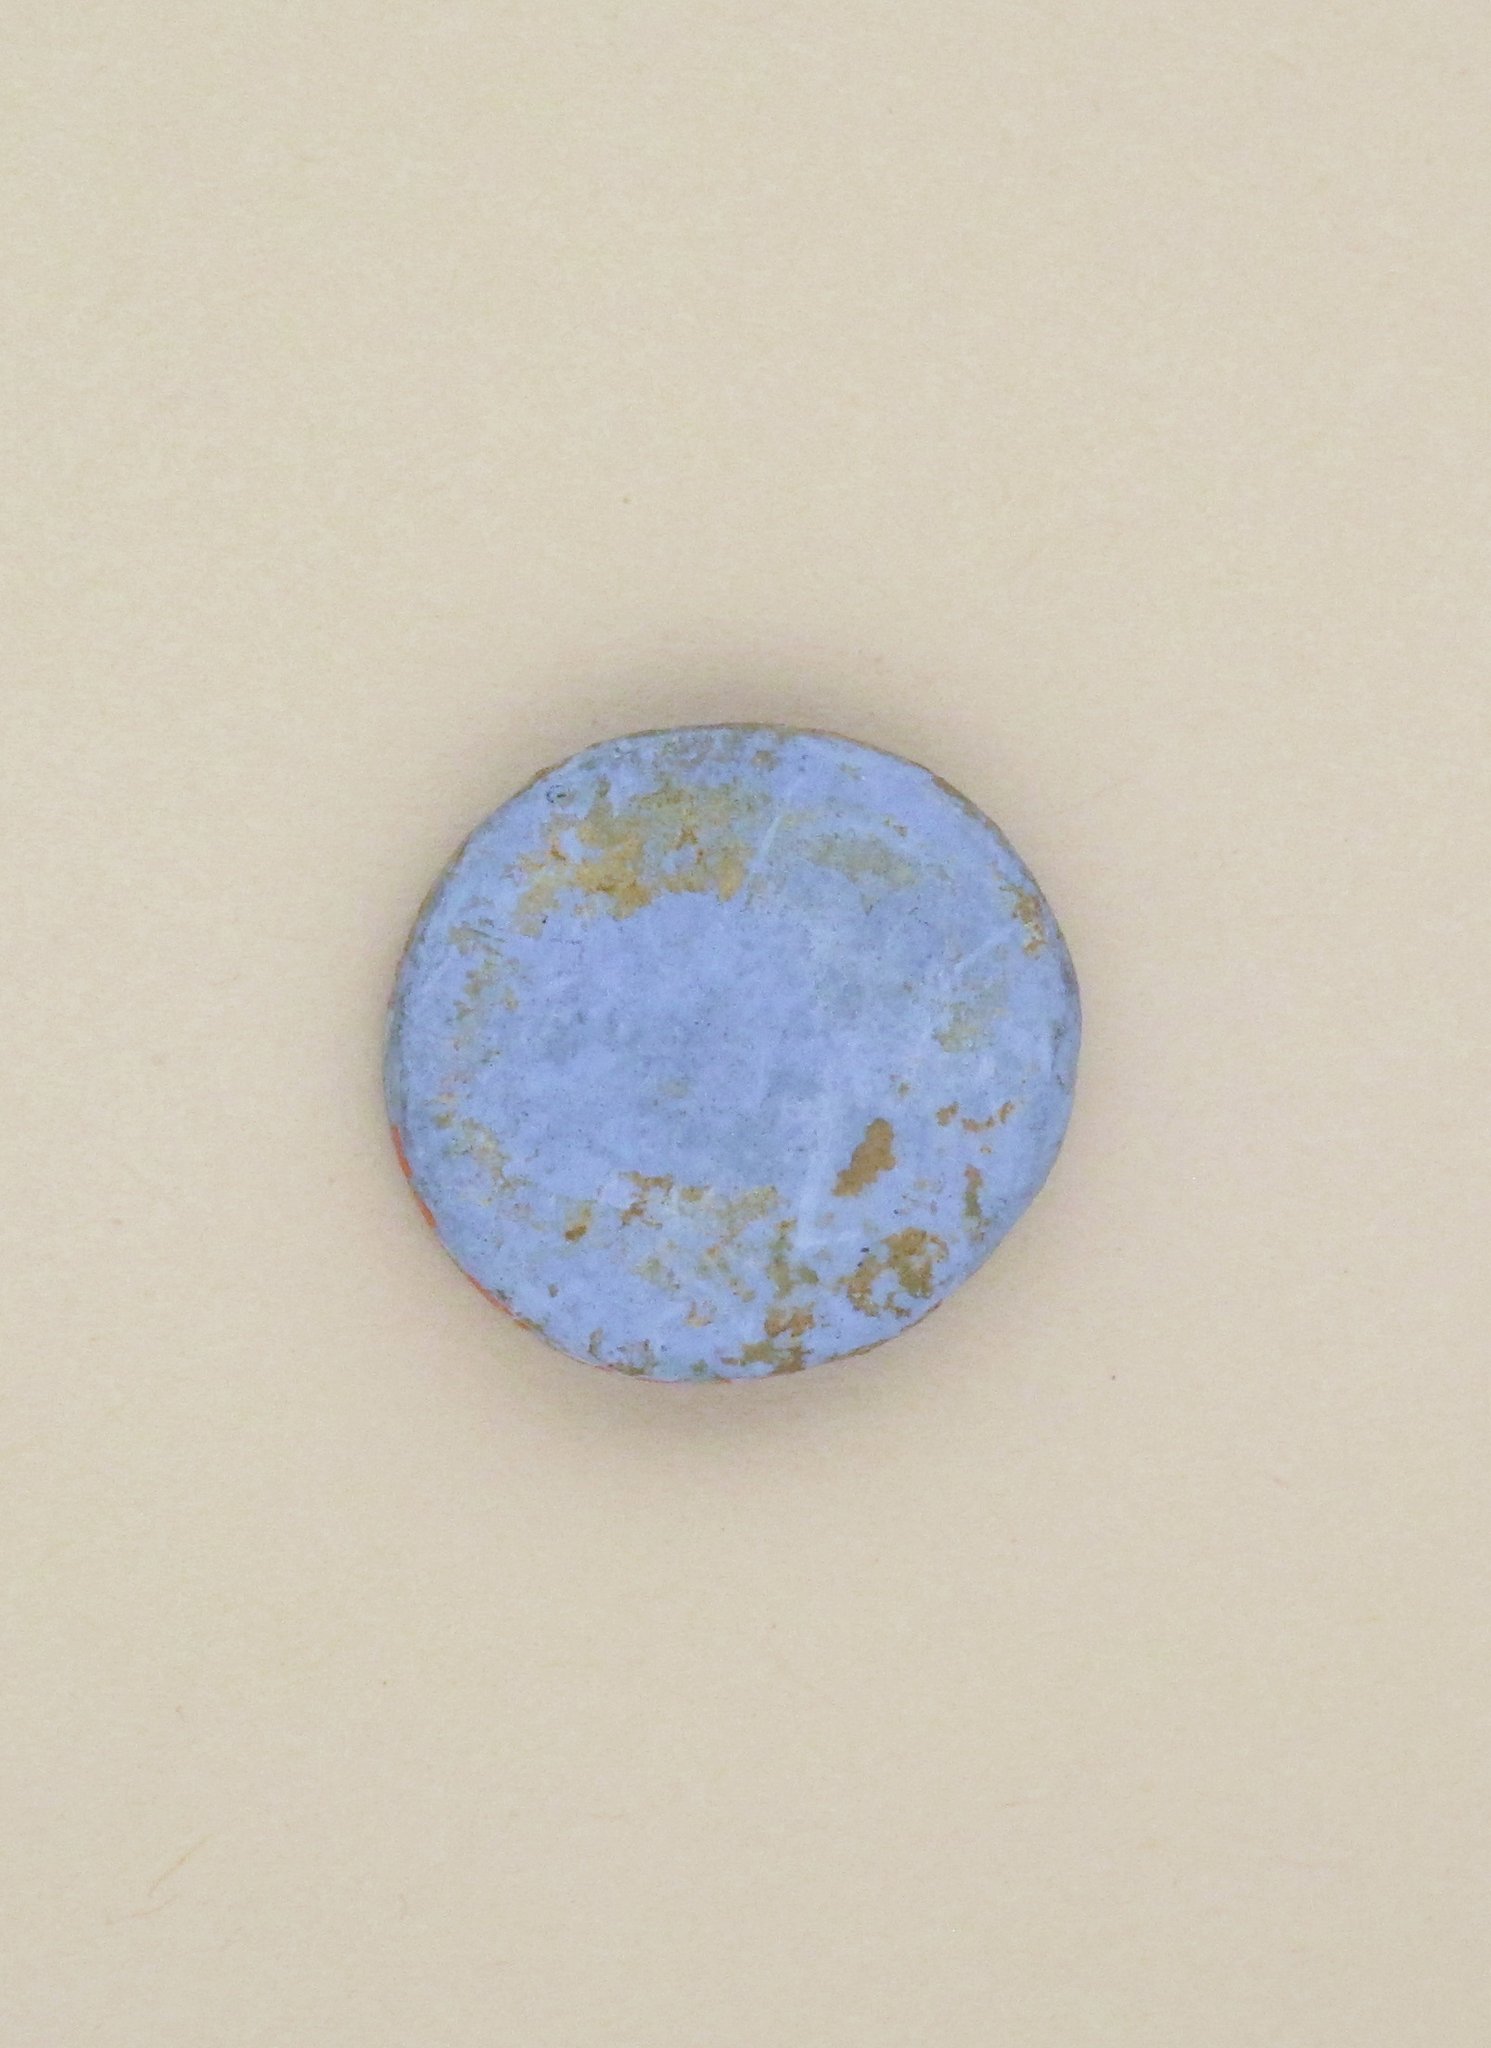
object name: bead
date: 7000 BCE-330 CE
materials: clay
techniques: glazing